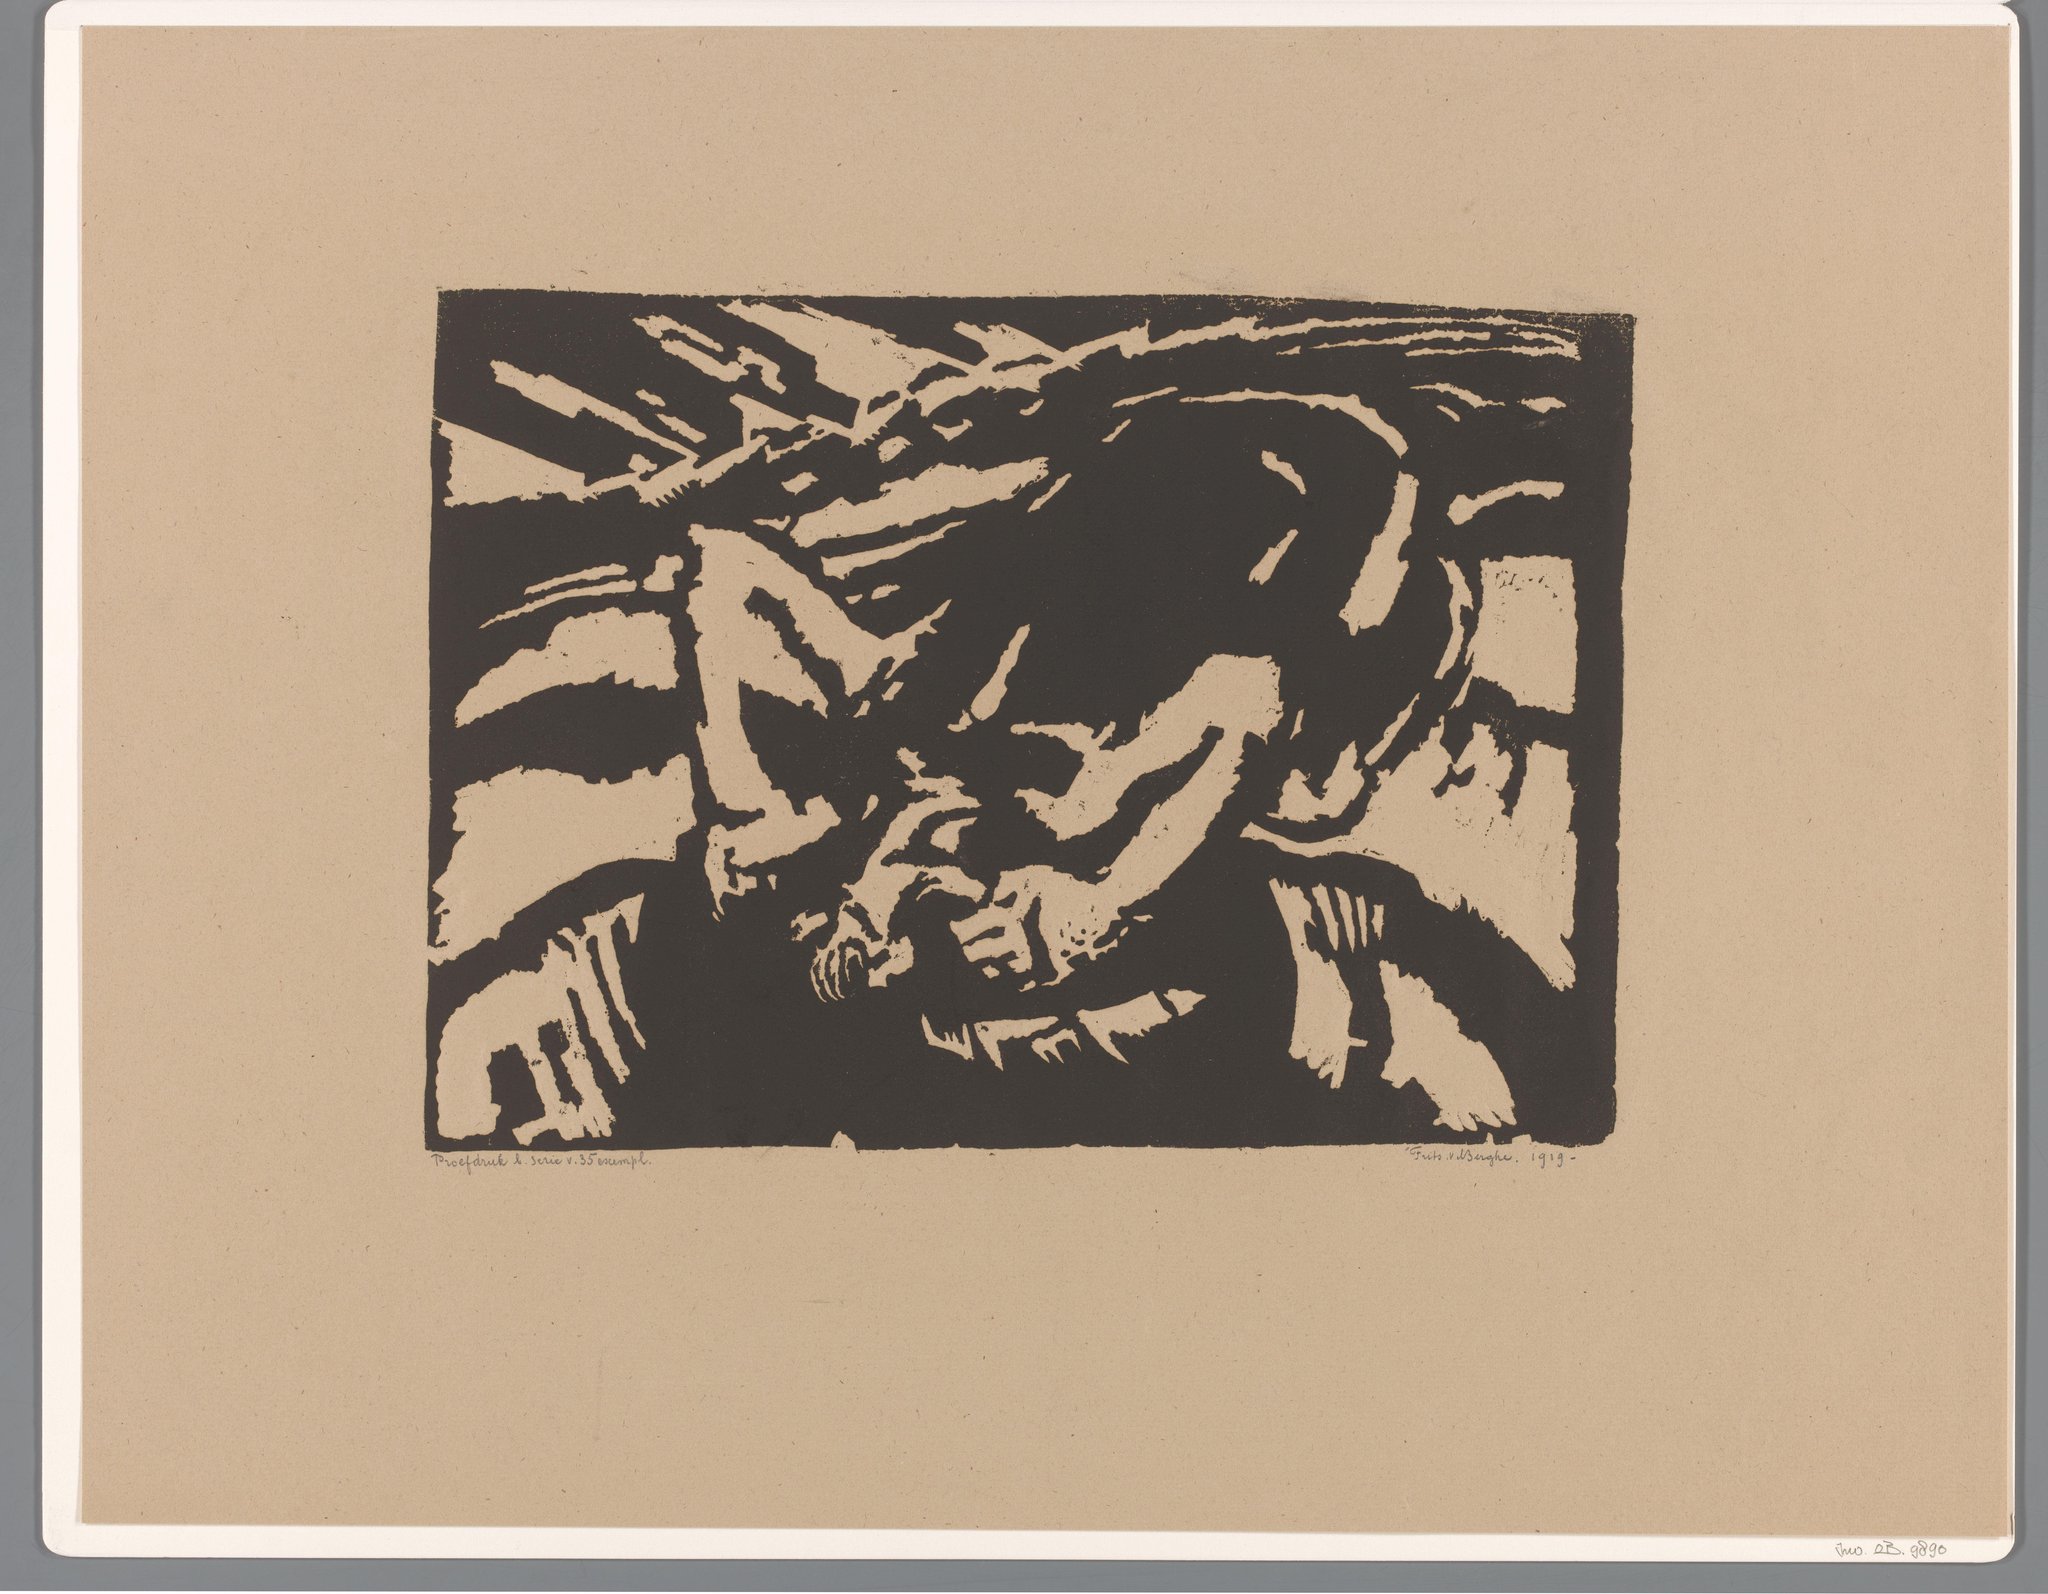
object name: print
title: Geknielde man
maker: frits van den berghe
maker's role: print maker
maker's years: 1883-1939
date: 1919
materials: paper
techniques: woodcut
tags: kneeling figure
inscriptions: annotation: ‘Proefdruk v. serie v. 35 exempl.’, collector's mark: Lugt 2228